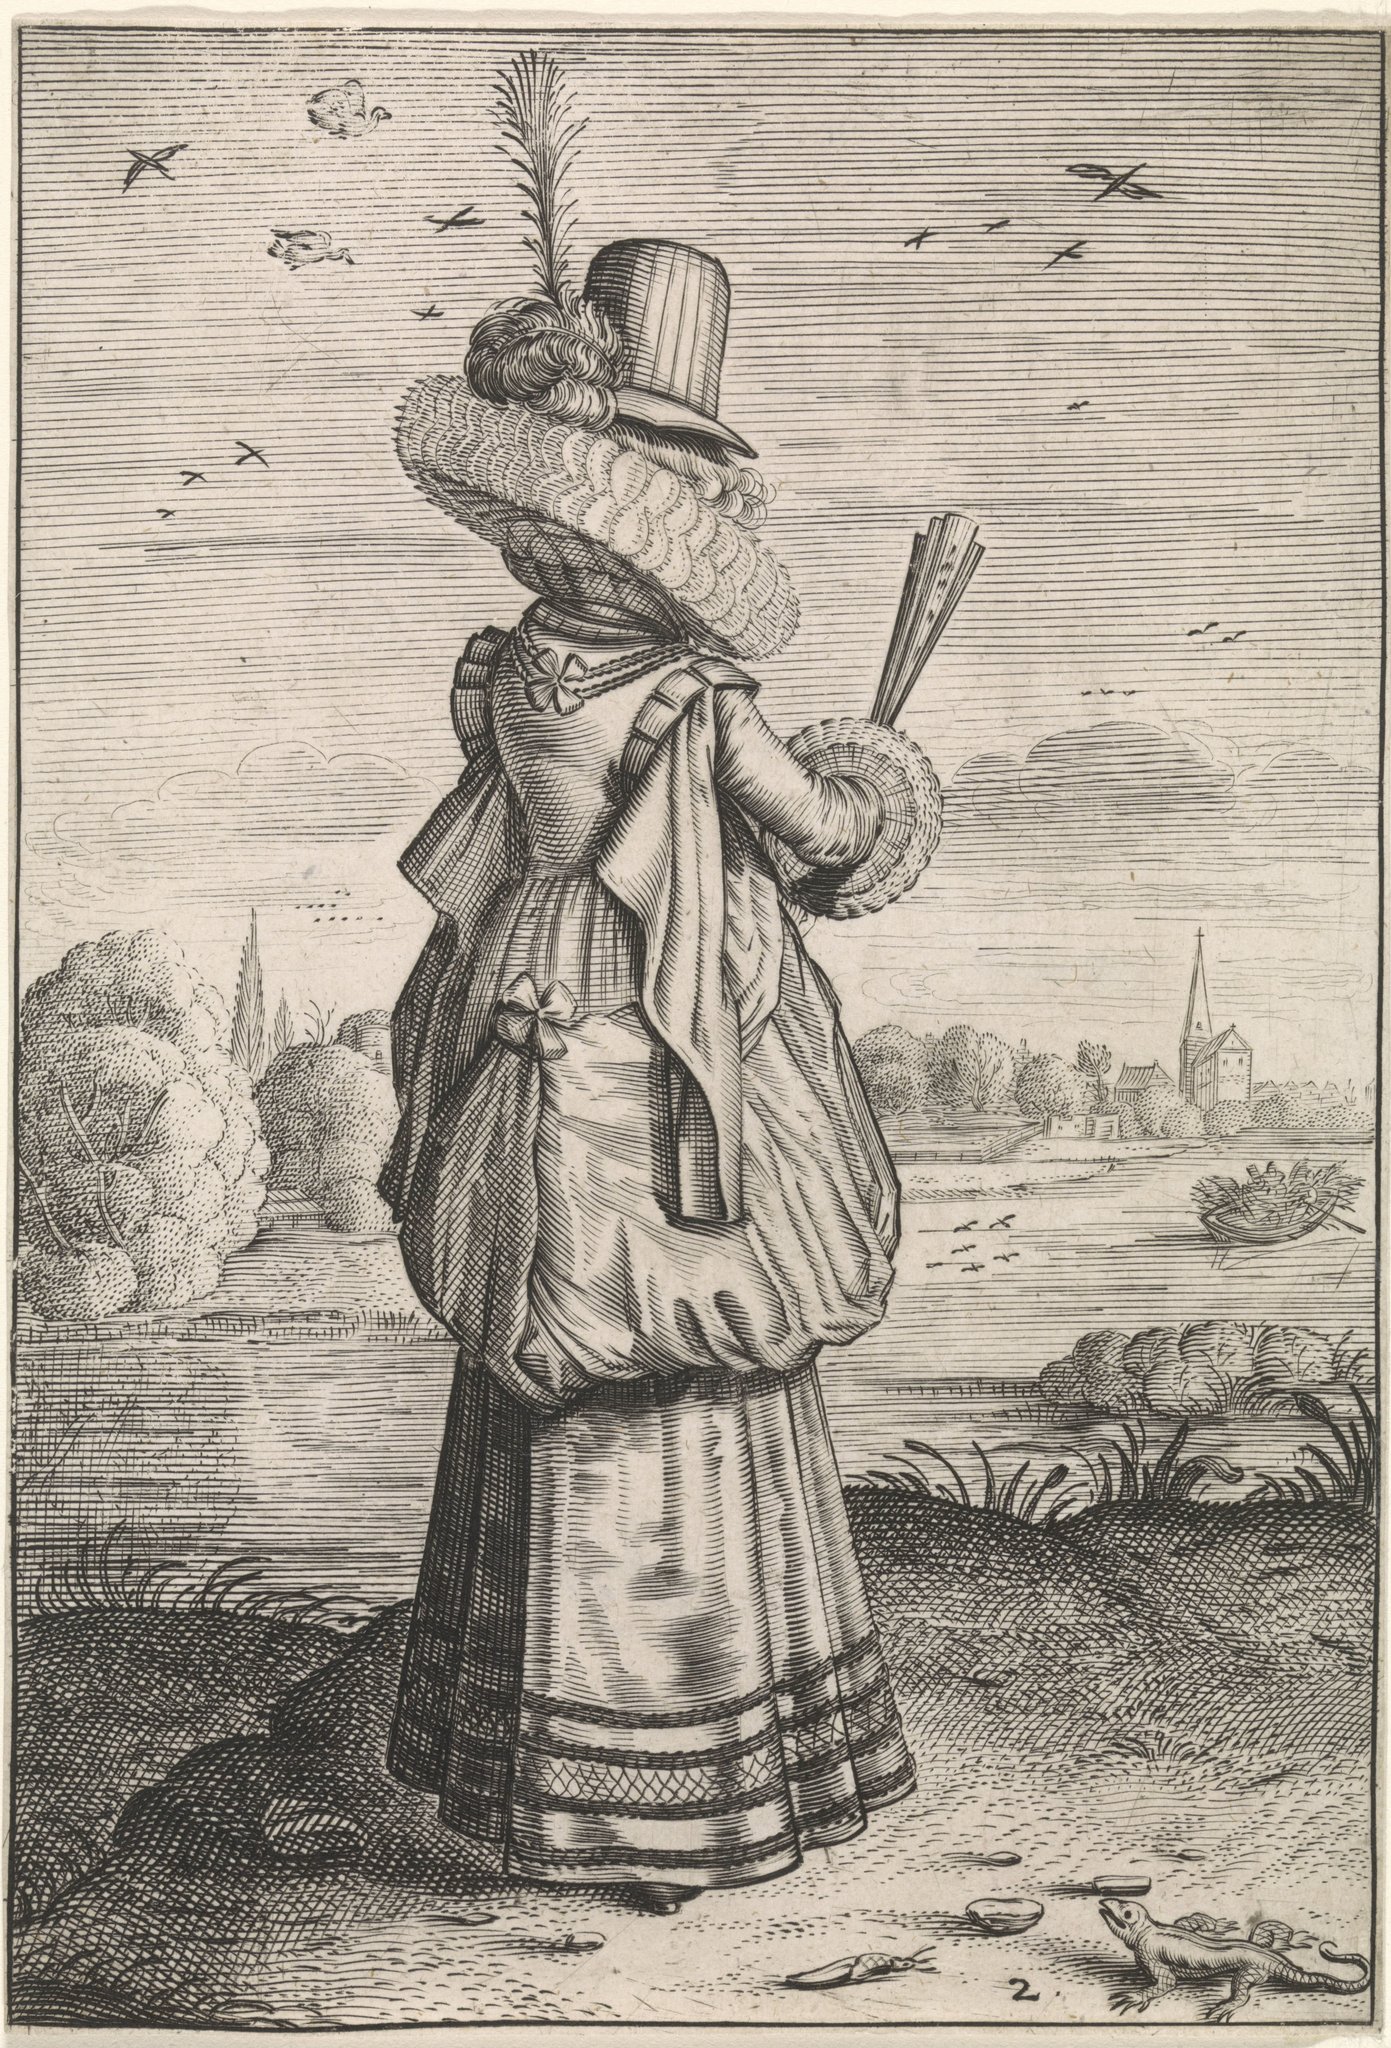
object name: costume print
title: Habitus et cultus Matronarum Nobilu et Rusticarum (Clothing and Manners of Noblewomen and Countrywomen)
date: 1619-1623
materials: paper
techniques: engraving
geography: haarlem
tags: head-gear: hat (+ women's clothes), neck-gear ~ clothing (with name) (+ women's clothes), sleeves: cuffs (+ women's clothes), dress, gown (+ women's clothes), lizards: lizard, fan, europeans (with name)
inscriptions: number: ‘2’, collector's mark: Lugt 240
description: This series highlights the contrast between the clothing of Dutch noblewomen and that of women from the provinces. The regional clothing evolves slowly over time, while the fashionable attire of the elite is subject to foreign influences. For example, the woman in plate 1 wears a Spanish, conical farthingale beneath her skirt, while the woman in plate 2 wears the bellshaped version from France.